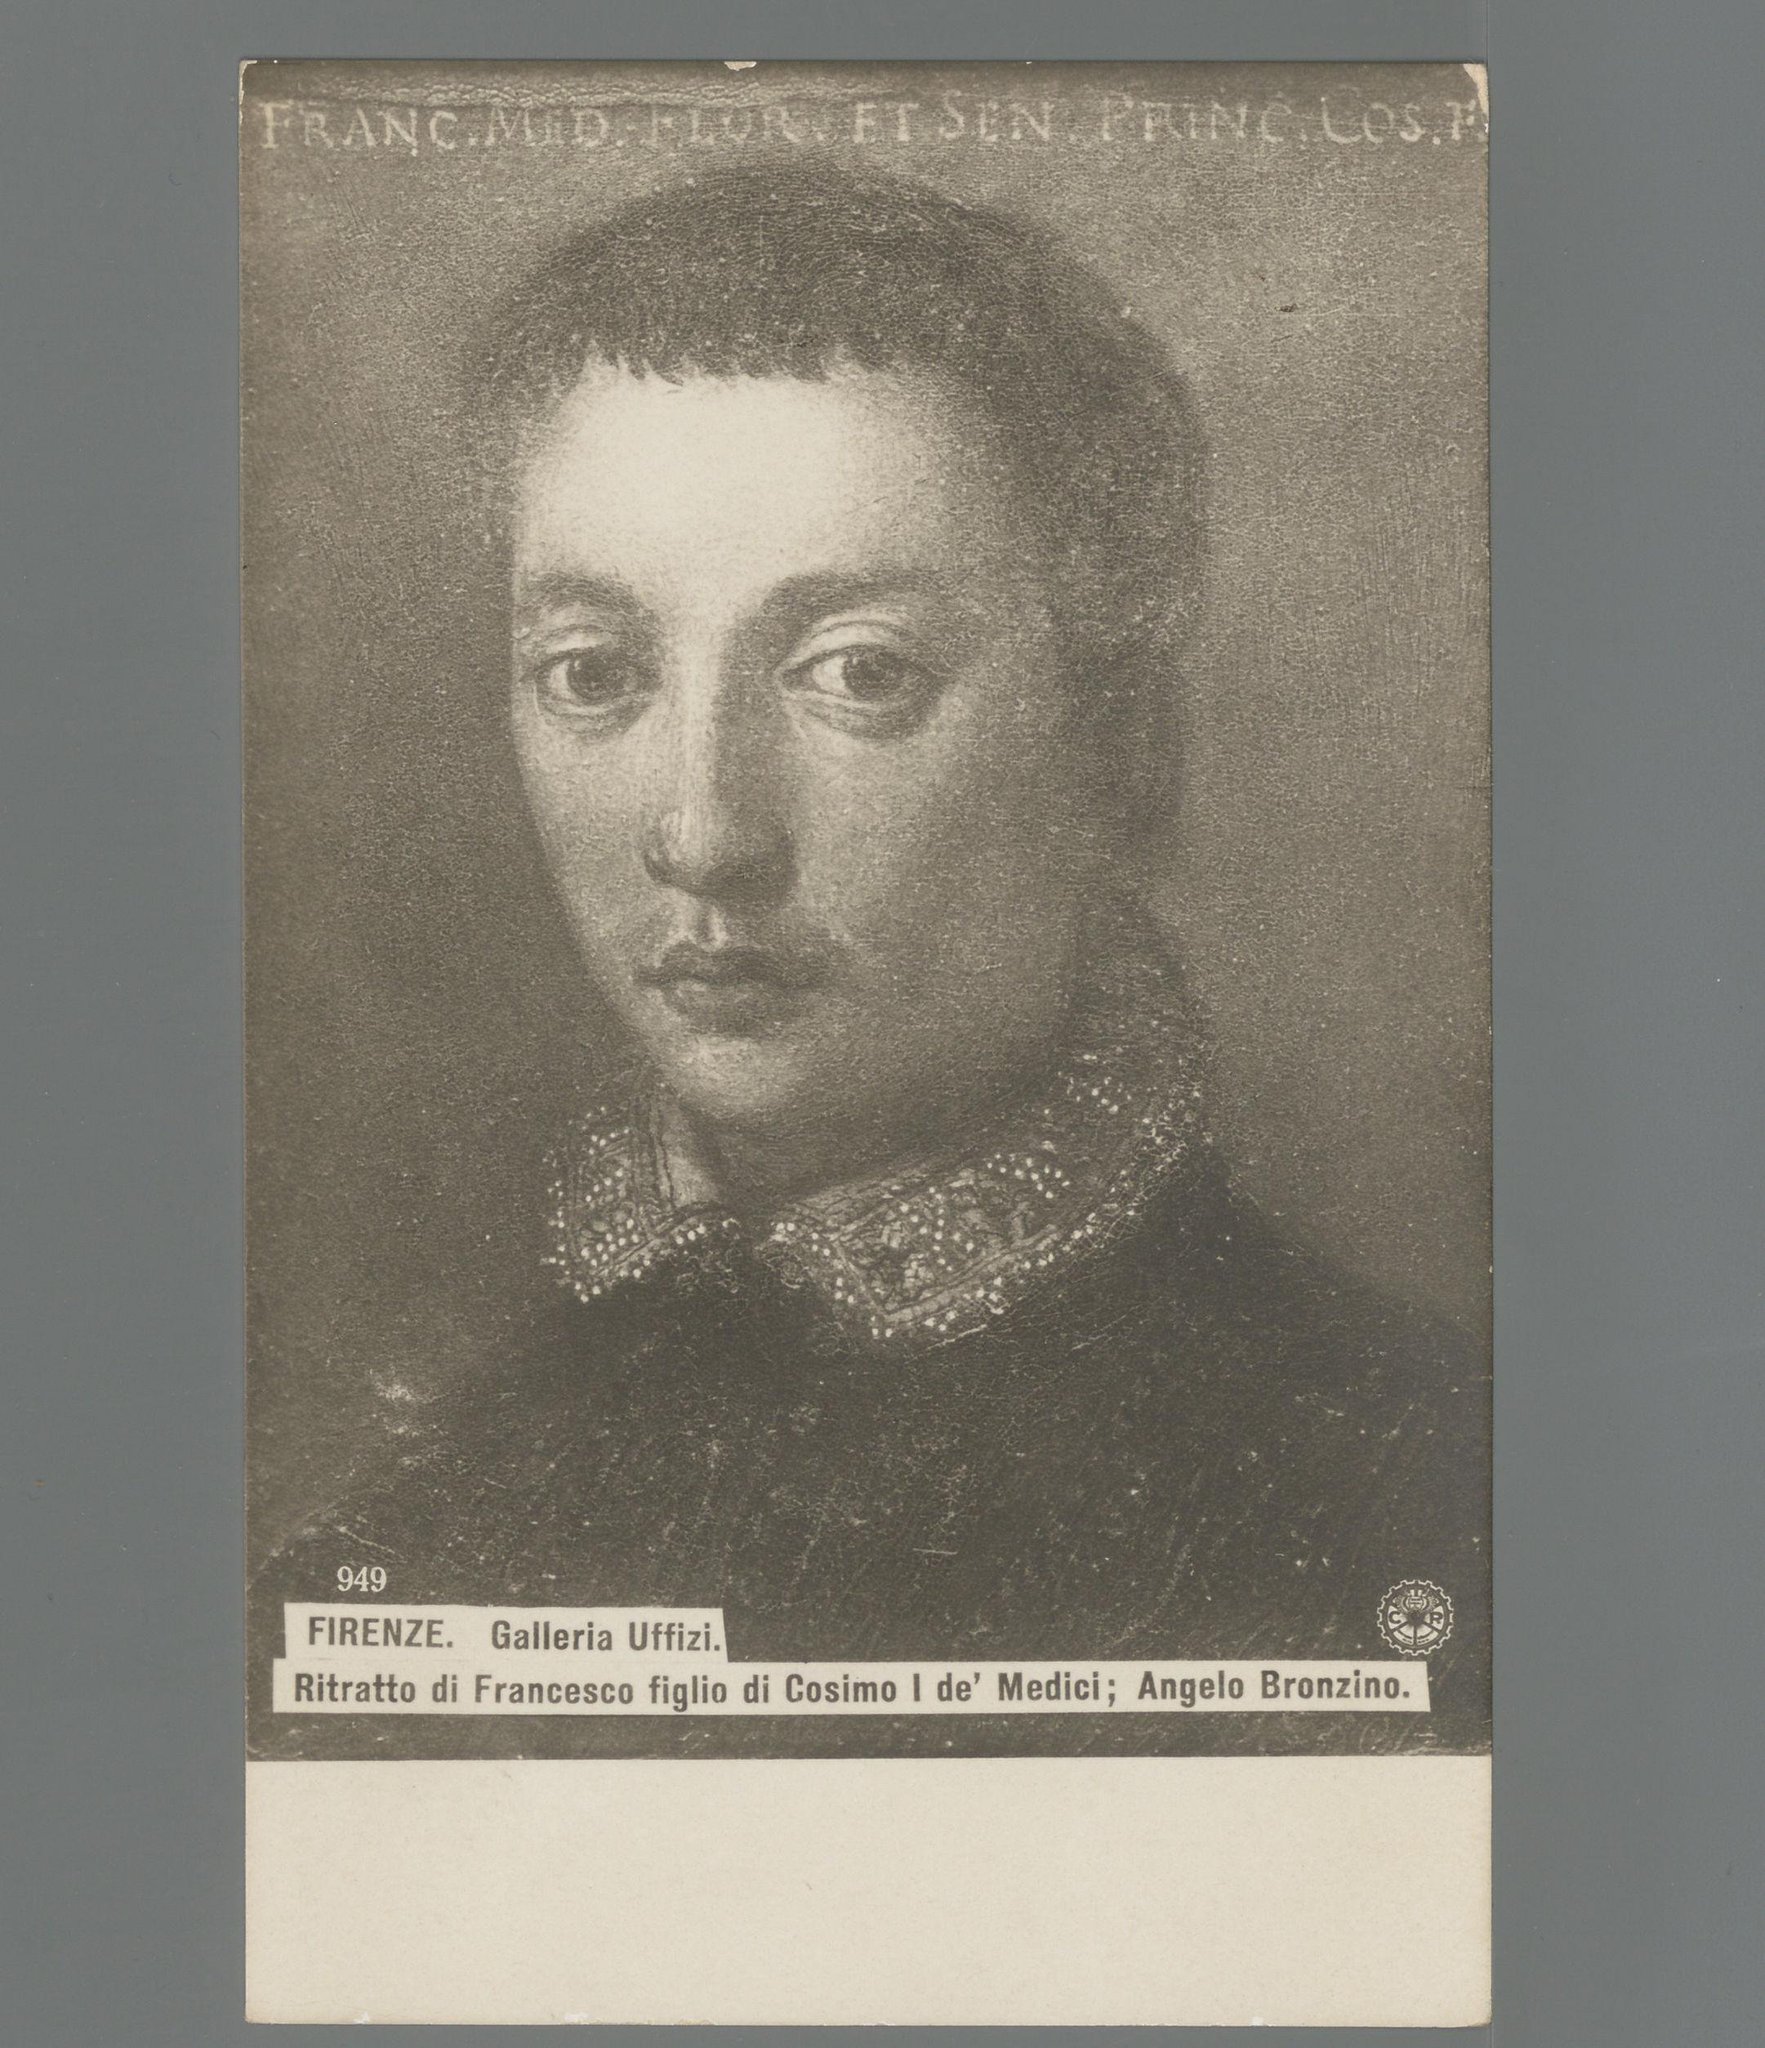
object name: ansichtkaart, prentbriefkaart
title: Firenze. Galleria Uffizi. Ritratto di Francesco figlio di Cosimo I de' Medici; Angelo Bronzino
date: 1906-1930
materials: photographic support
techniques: photography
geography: florence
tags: francesco i de' medici, historical persons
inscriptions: collector's mark: ‘AFE v S’